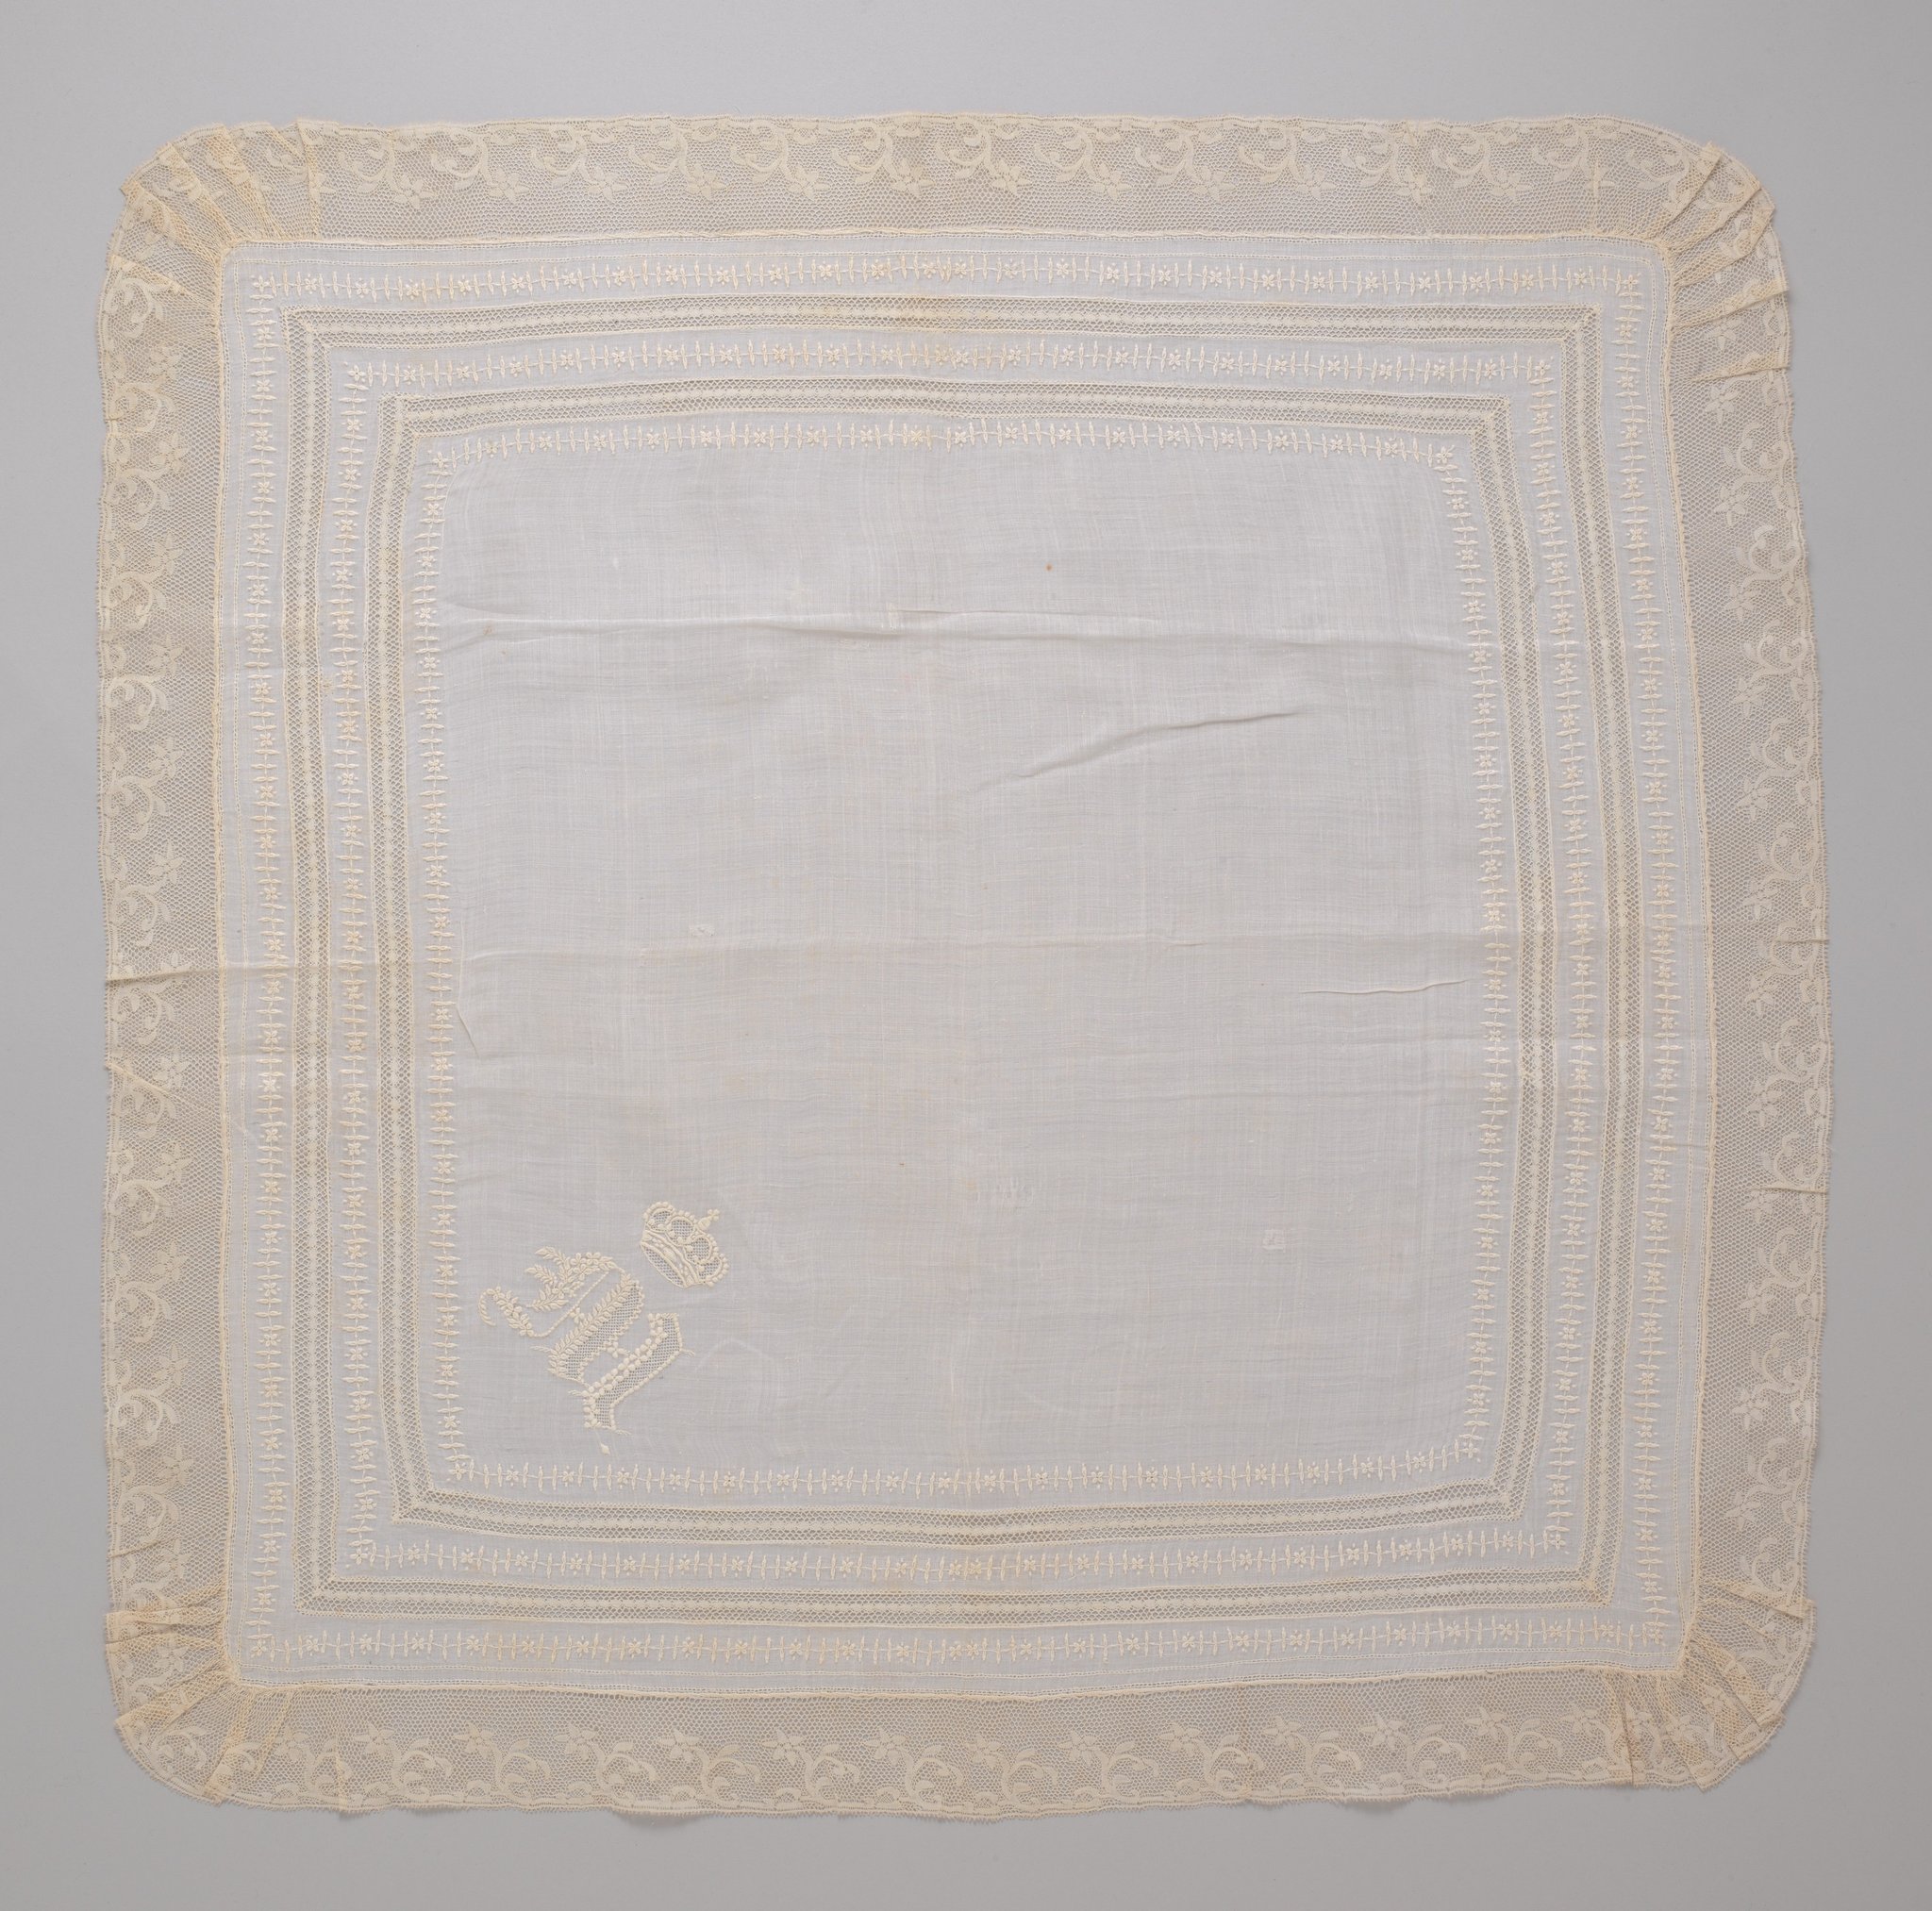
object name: handkerchief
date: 1840-1880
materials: linen, silk